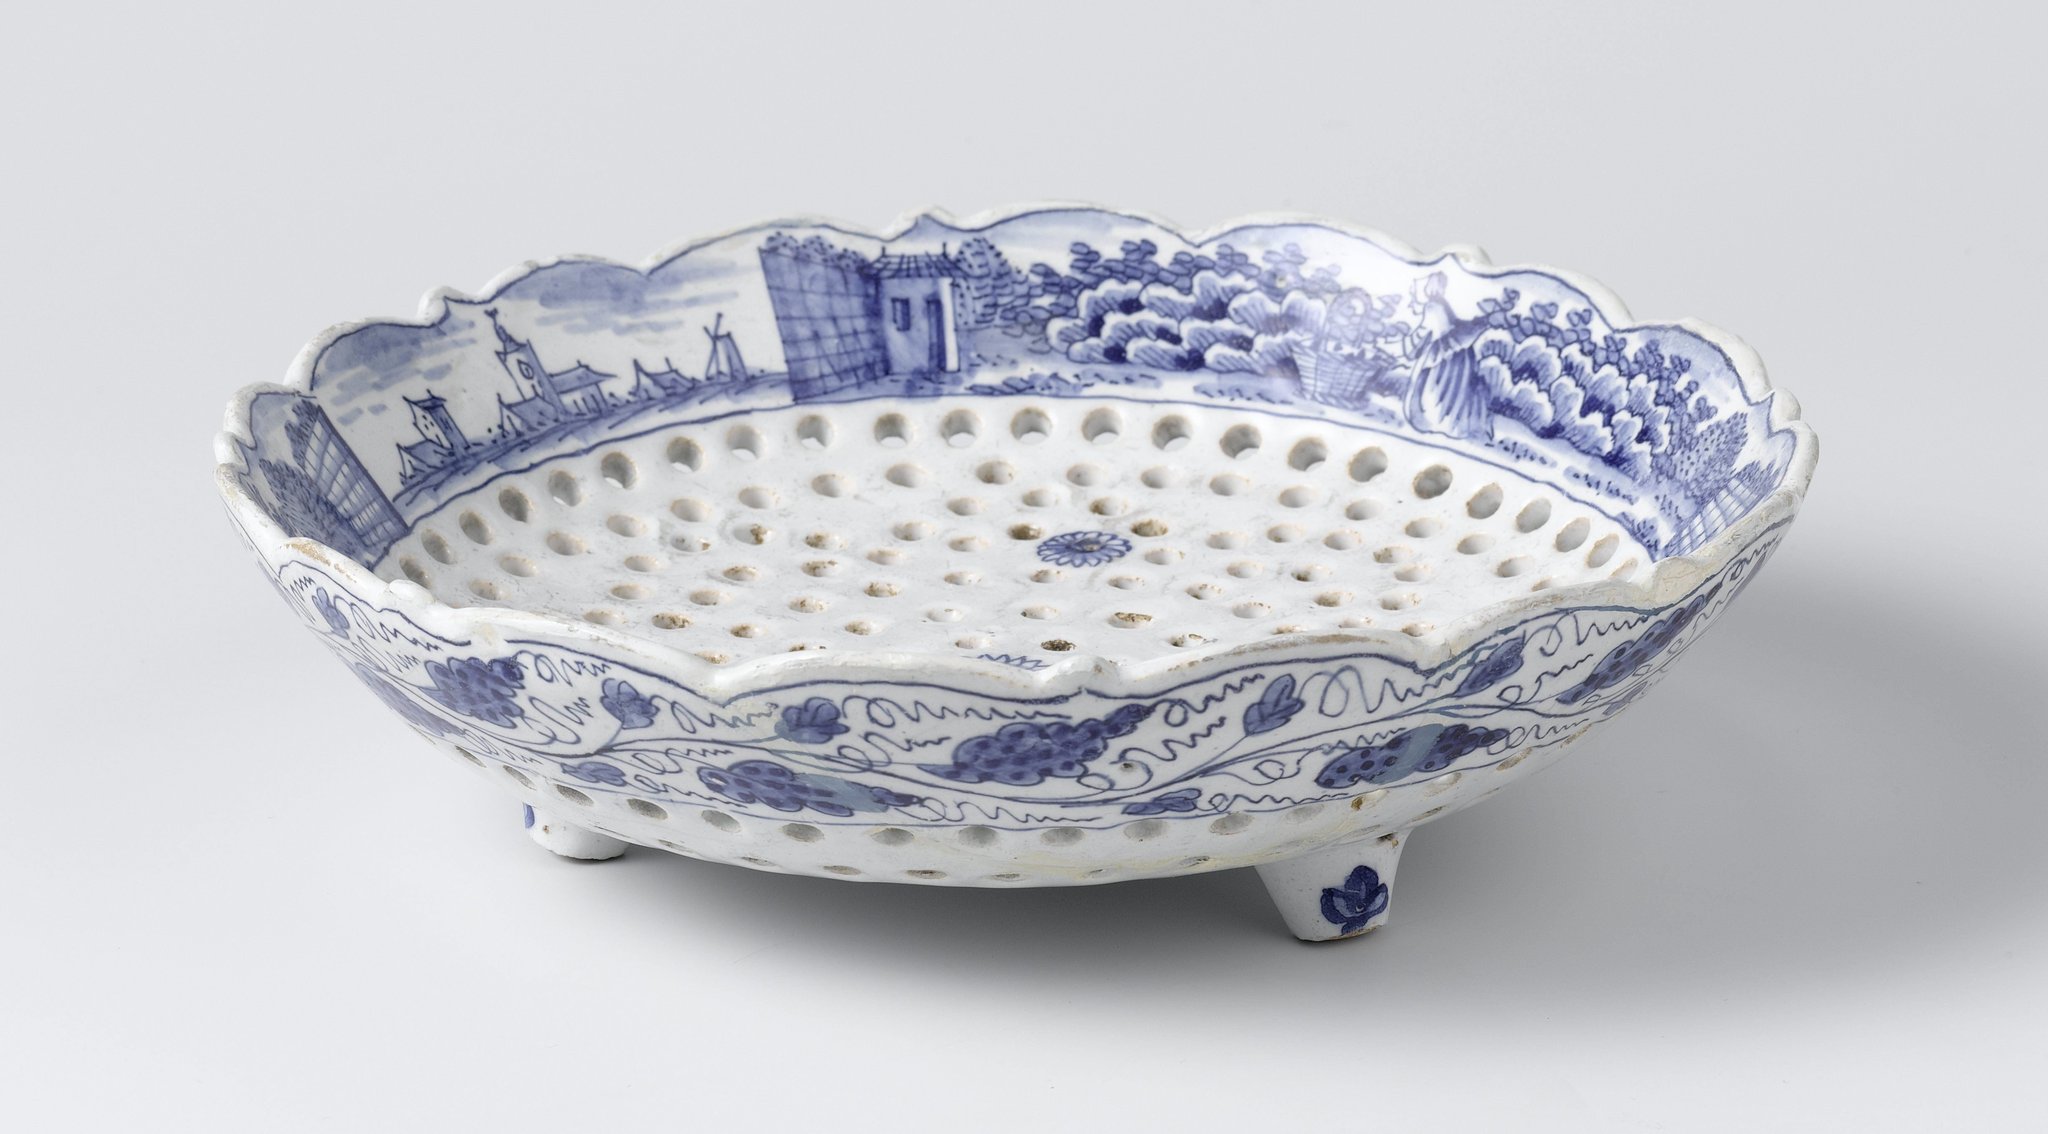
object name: dish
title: Natfruitschaal van blauw beschilderde faience, met gaatjes in een bloemvorm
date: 1739-1785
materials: faience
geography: delft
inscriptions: mark: ‘IB(ineen)’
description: Natfruitschaal met gaatjes in een bloemvorm, in blauw beschilderde faience. Onderschotel ontbreekt.